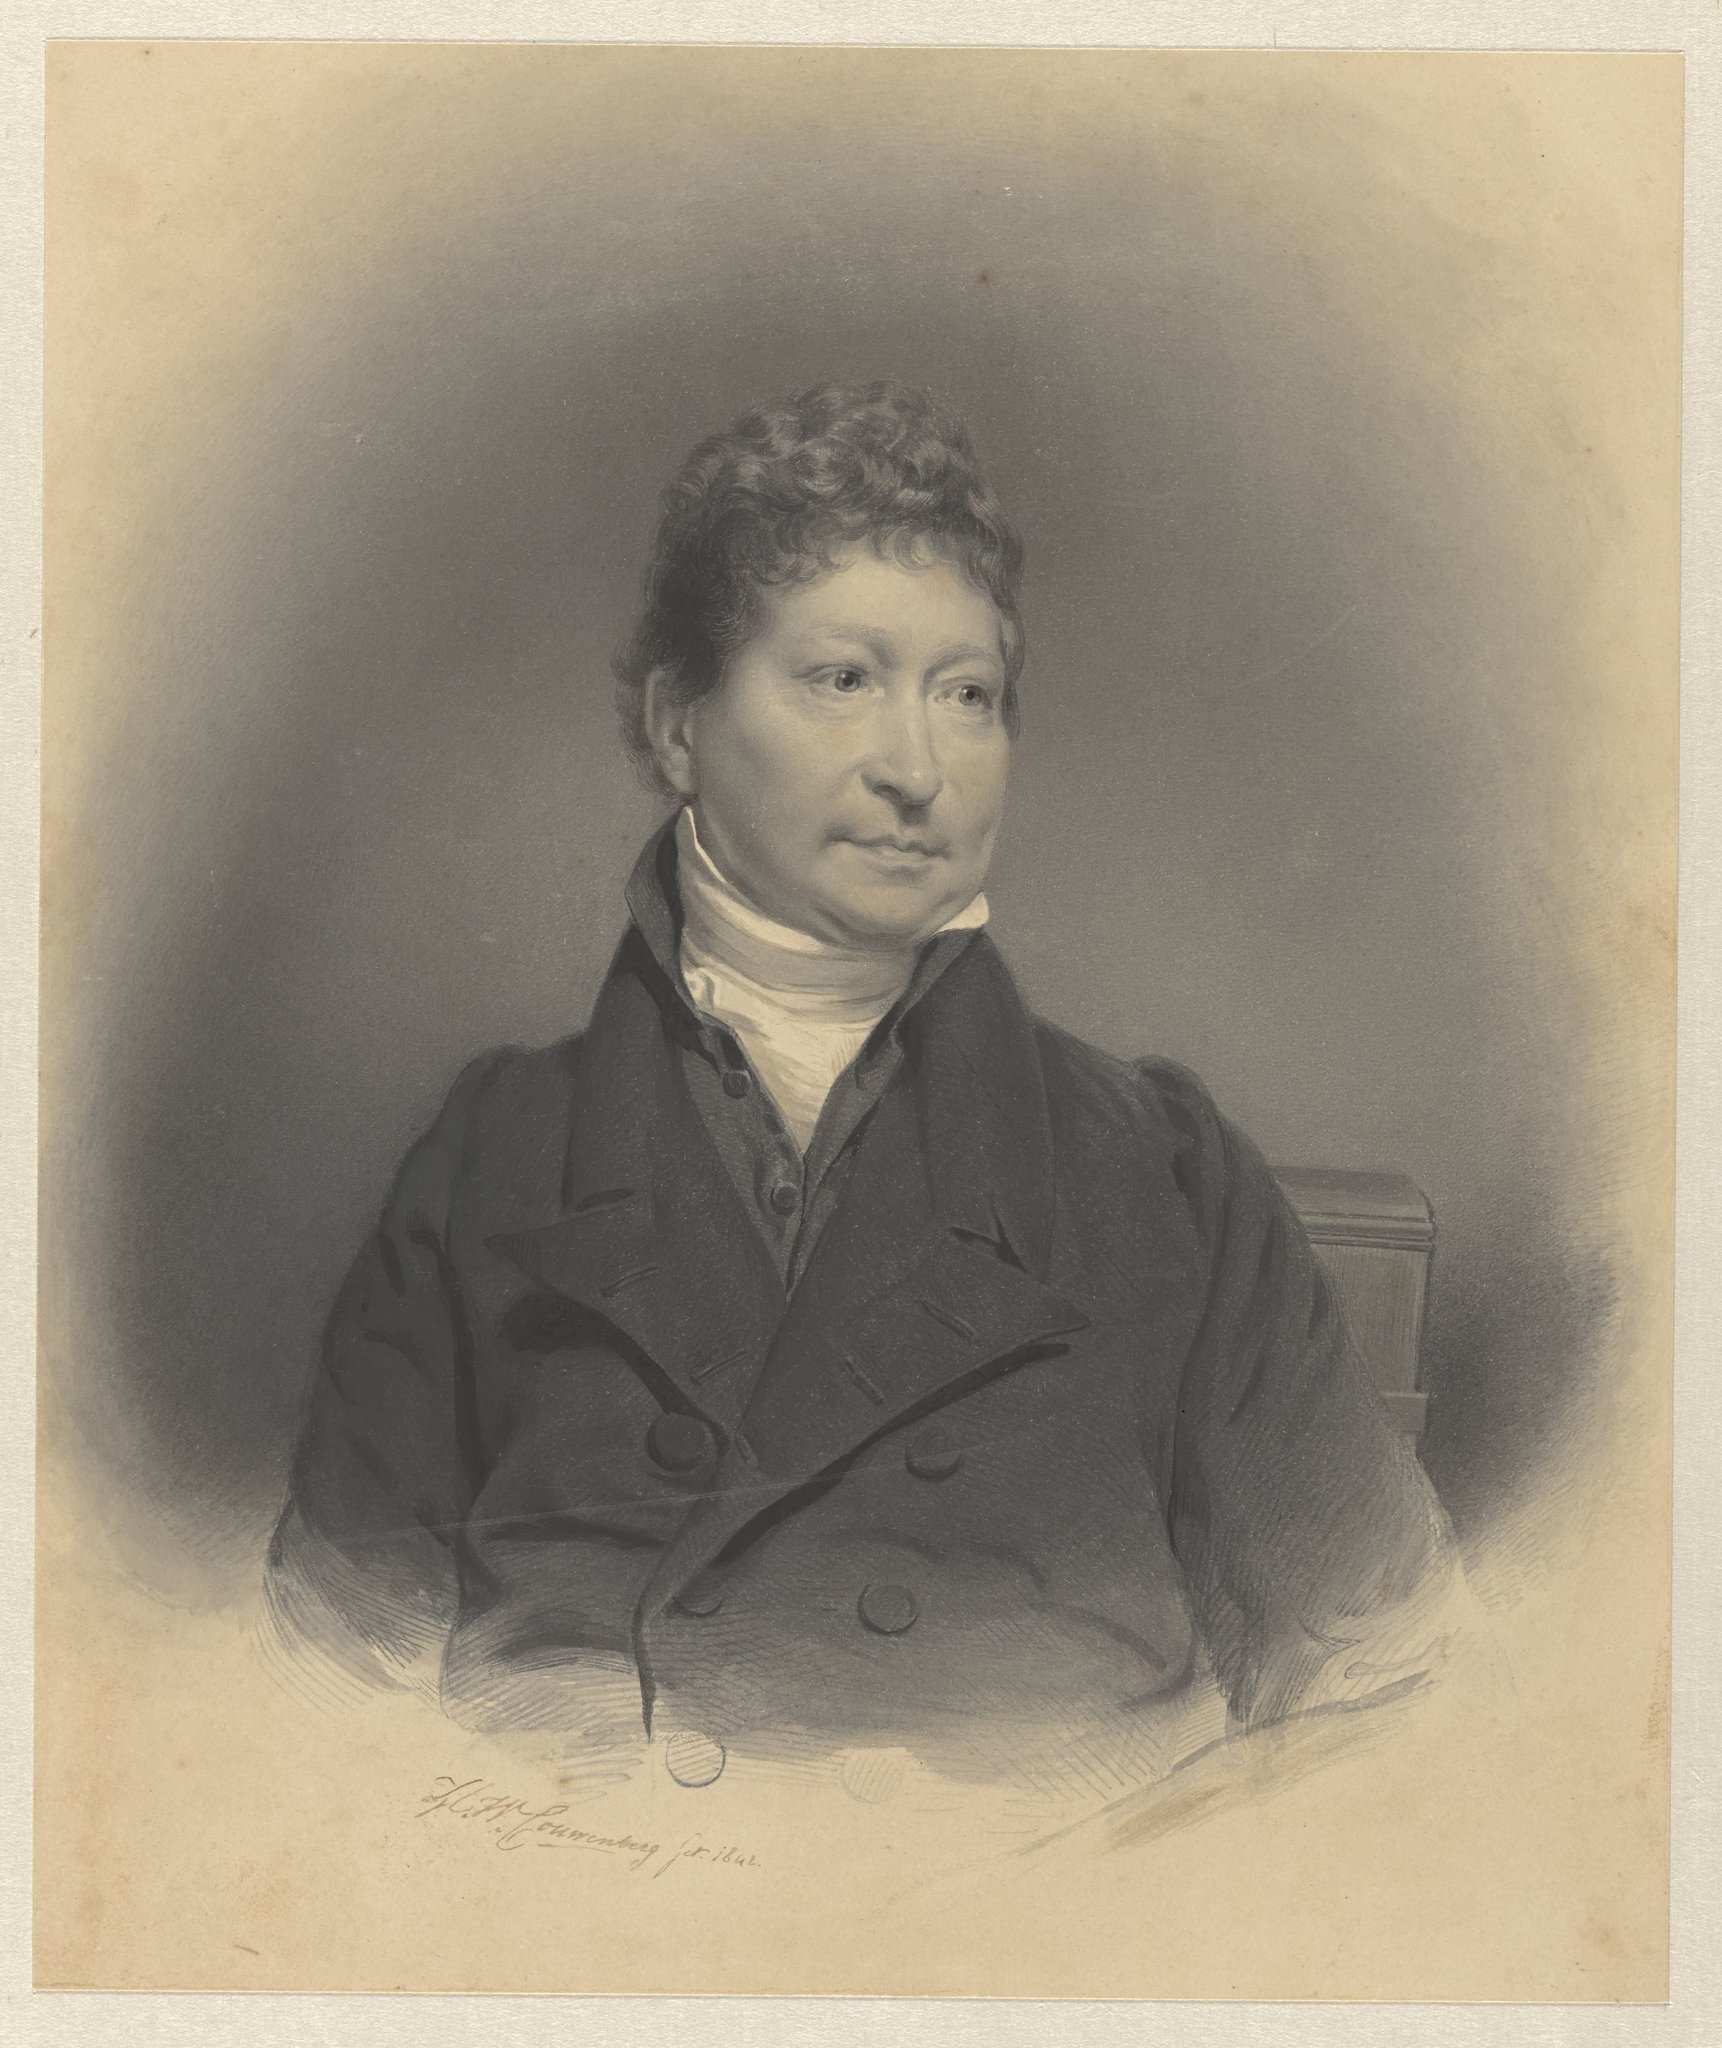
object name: drawing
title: Portret van F. Mispelblom Beyer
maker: henricus wilhelmus couwenberg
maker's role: draughtsman, print maker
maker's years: 1814-1845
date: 1842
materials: paper, pencil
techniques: brush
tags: historical persons